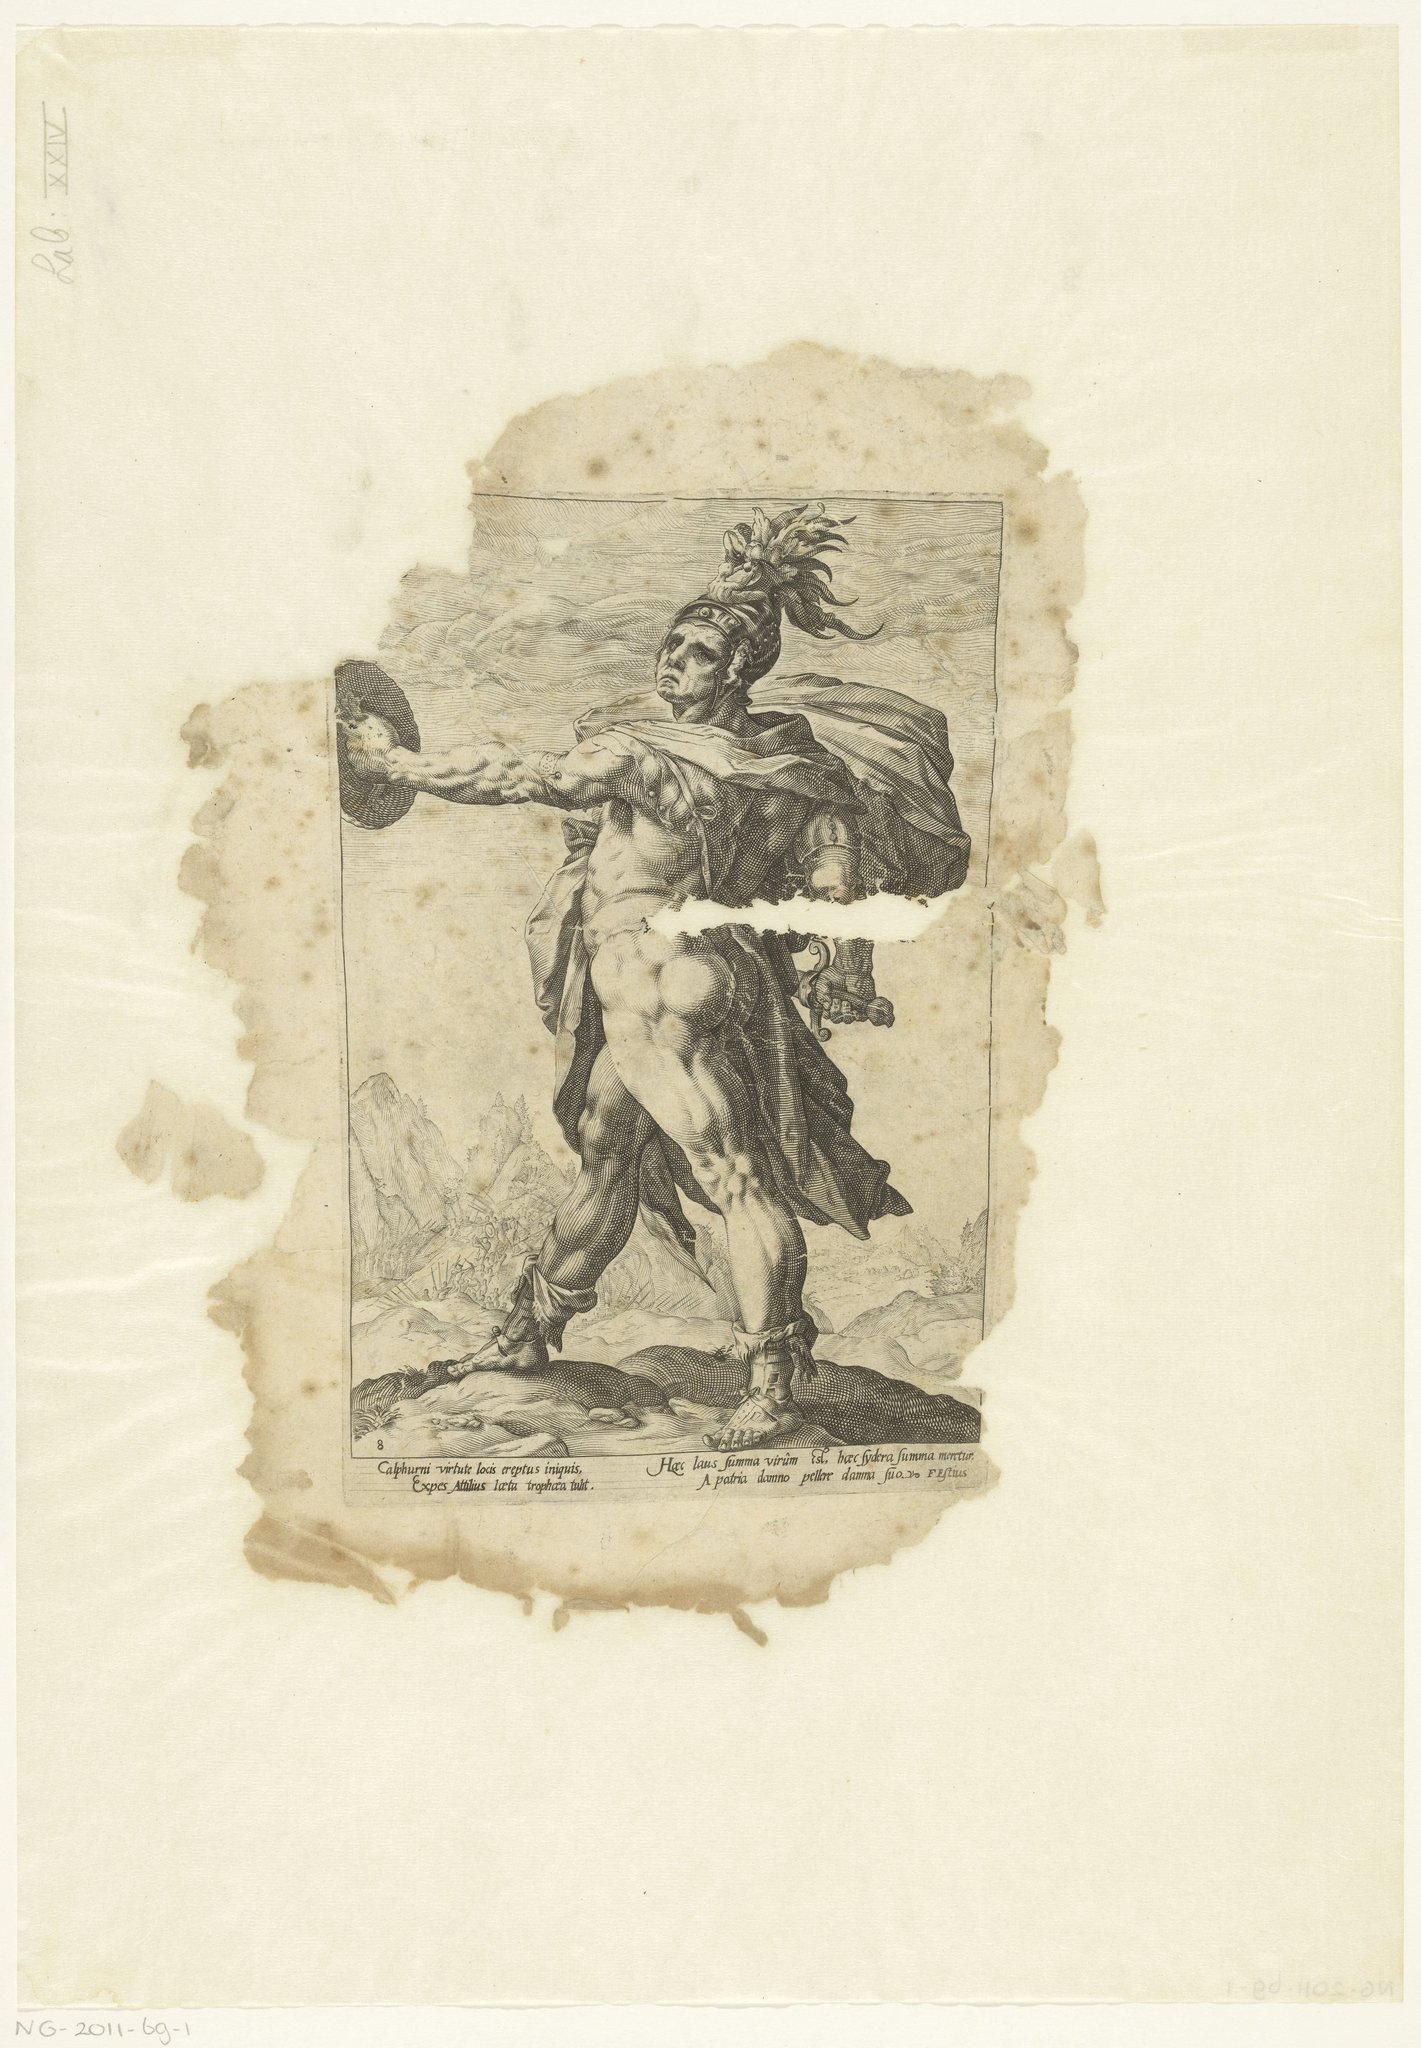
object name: print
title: Romeinse helden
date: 1586-1596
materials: paper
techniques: engraving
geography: northern netherlands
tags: male persons from classical history (calpurnius, m.)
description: Deze prent is onderdeel van een serie van tien prenten, bestaand uit een ongenummerde titelprent, acht genummerde voorstellingen van helden en een ongenummerde afsluitende prent. De prenten in de Nova Zembla collectie zijn tijdens een expeditie van Willem Barendsz en Jacob van Heemskerk in 1596-1597 noodgedwongen in het winterkamp, het ‘Behouden Huis’, op het eiland achtergelaten. De prenten waren in één of meerdere stapels als handelswaar meegenomen vanuit Amsterdam. Bijna drie eeuwen later, in 1871, keerde de Noor Elling Carlsen terug naar Nova Zembla en vond daar de restanten van het ‘Behouden Huis, inclusief een groot deel van de inventaris. Een deel van de prenten, in de vorm van aaneengekoekte kluiten, werd toen ook teruggevonden. De papierkluiten waren soms op meerdere plekken gebroken. Tussen 1975-1979 zijn de prenten van elkaar gescheiden. Dit leverde in totaal ca. 1000 fragmenten van ca. 400 afdrukken van ca. 150 verschillende prenten op. Voor zover mogelijk zijn de fragmenten samengevoegd en zijn de prenten gereconstrueerd.